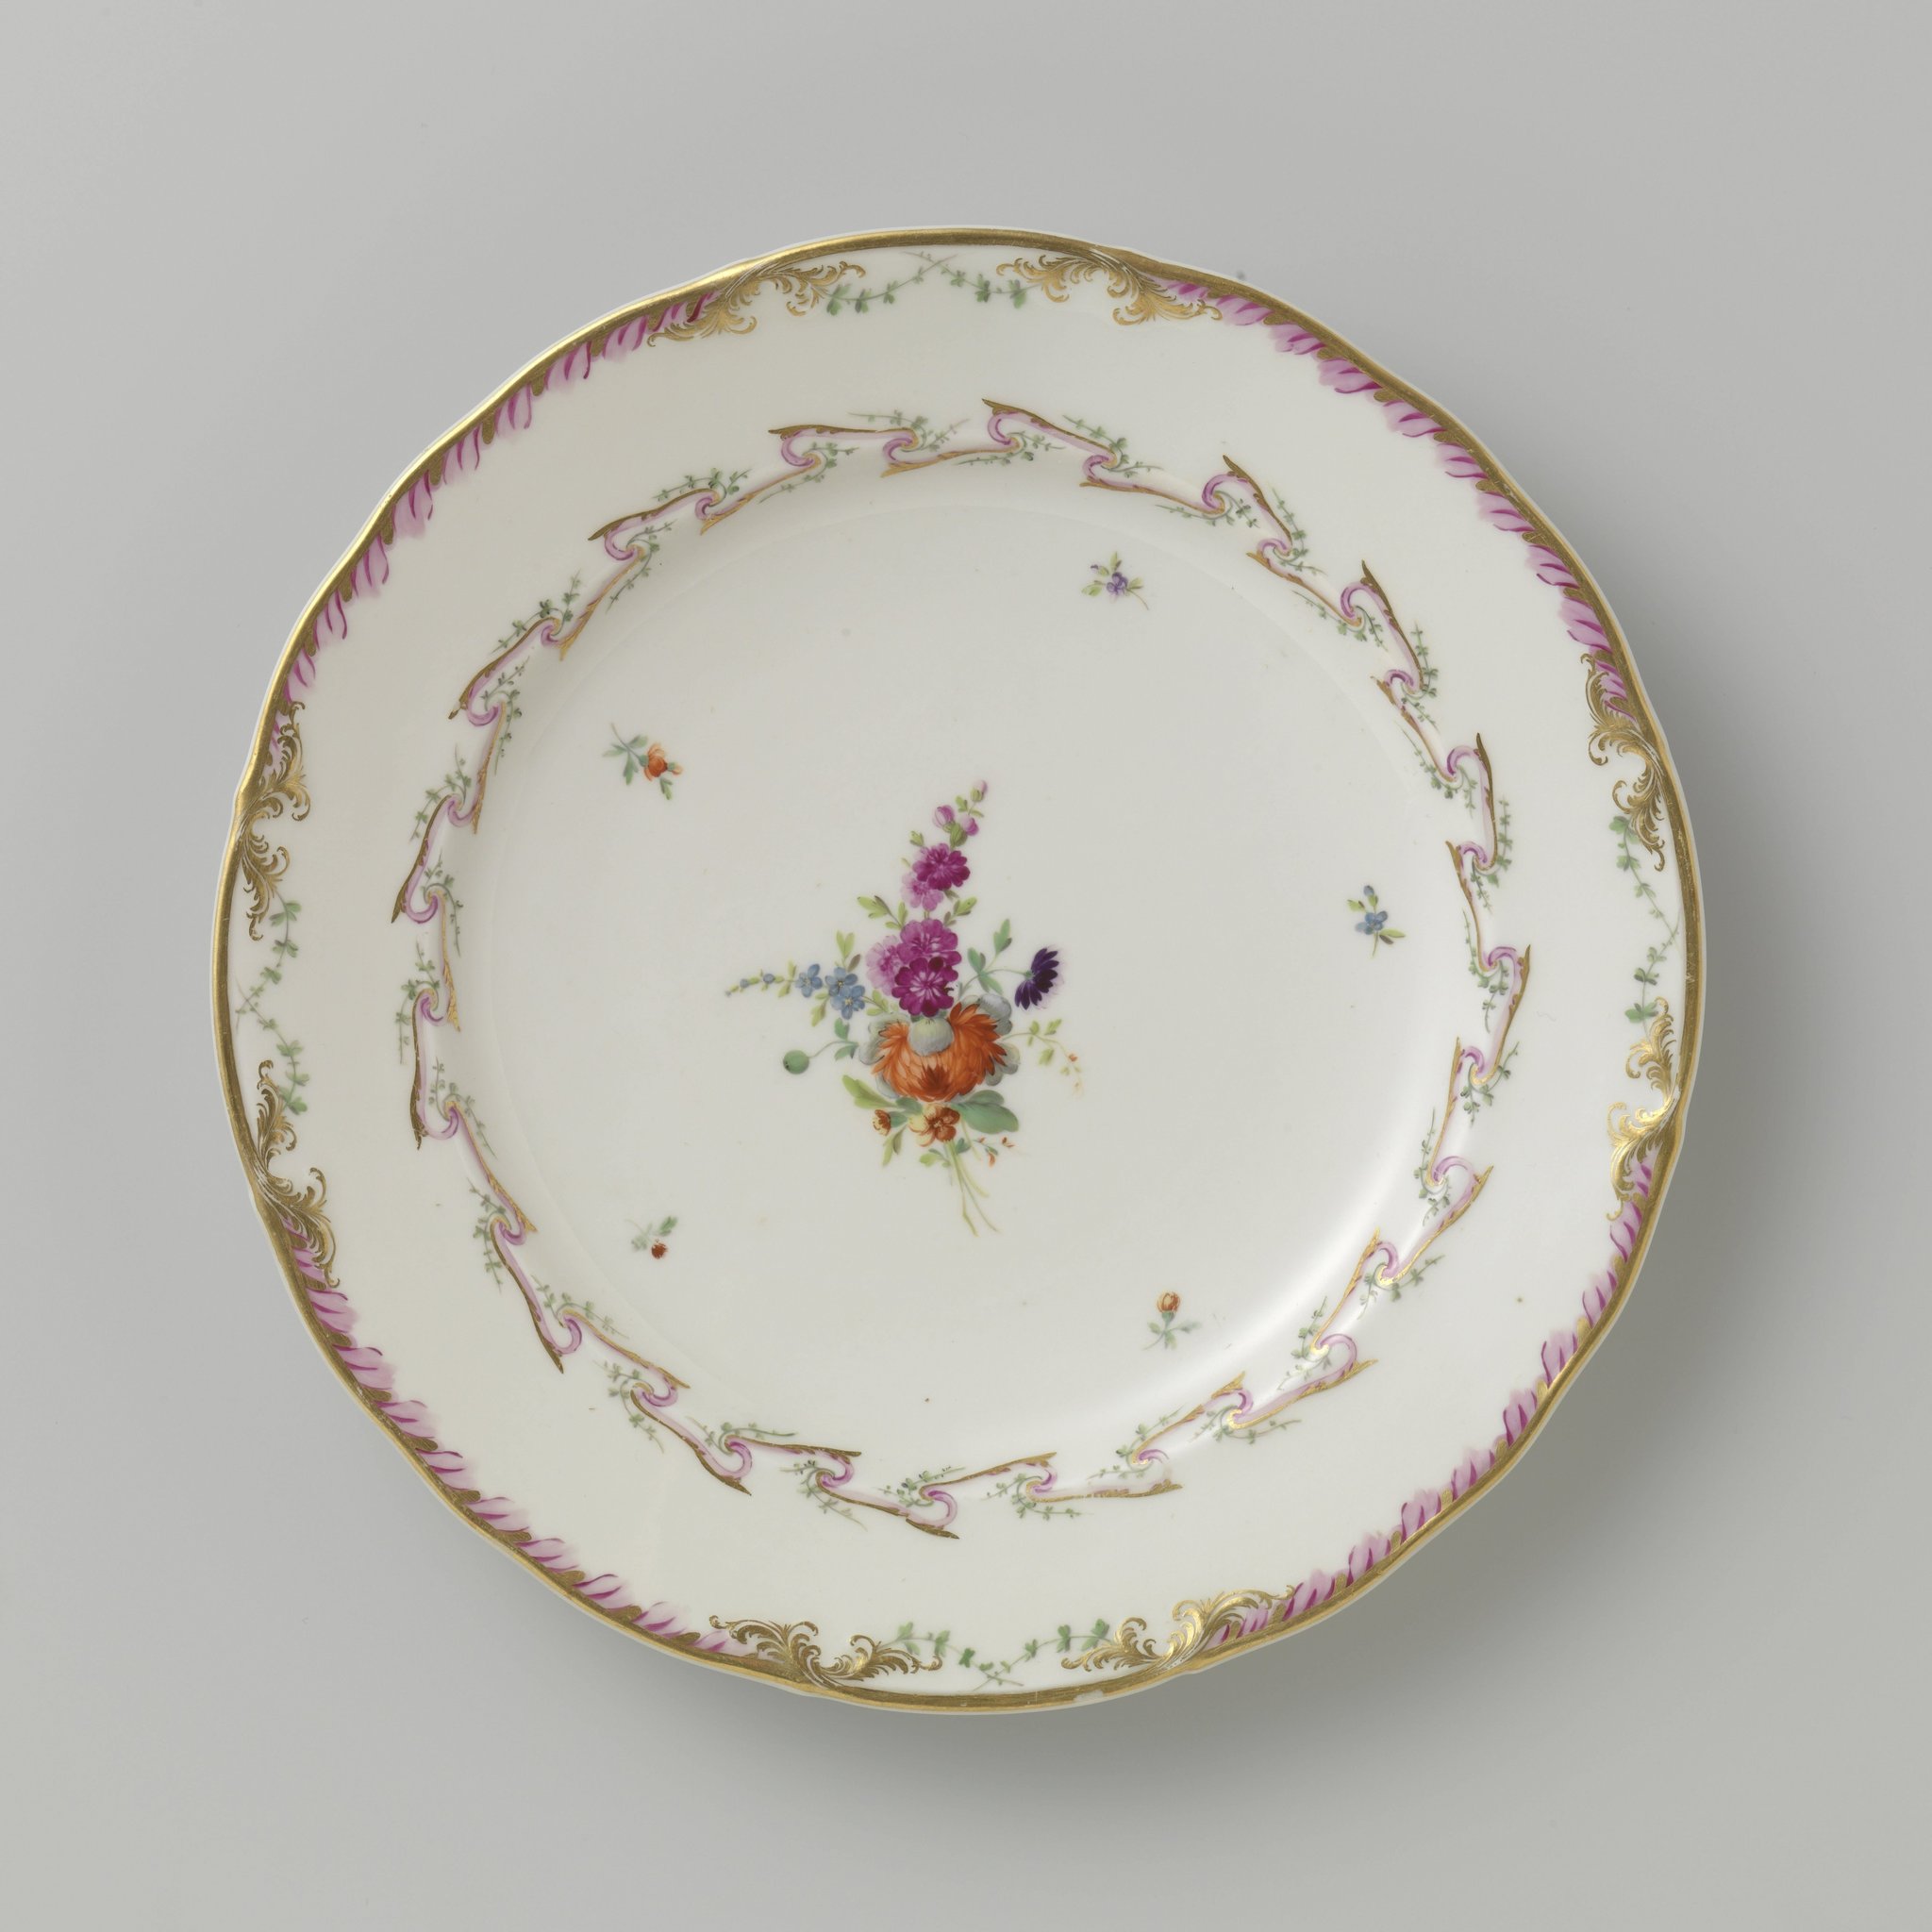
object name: plate dish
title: Bord, plat model, behorend bij een servies met geslingerd lintmotief met bladertakken, bloemboeketten en gestrooide bloemtakken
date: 1780-1820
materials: porcelain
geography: paris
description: Bord, plat model, behorend bij een servies van porselein met geslingerd lintmotief in paars en goud met groene bladertakken, bloemboeketten en gestrooide bloemtakken. Randen lichtgegolfd met decoratie in goud met paars bladmotief waartussen groen gekruist bladmotief. Gemerkt: Mf. DE DIHL ET GUERHARD à PARIS. Serie van elf stuks. Opmerking: modern.